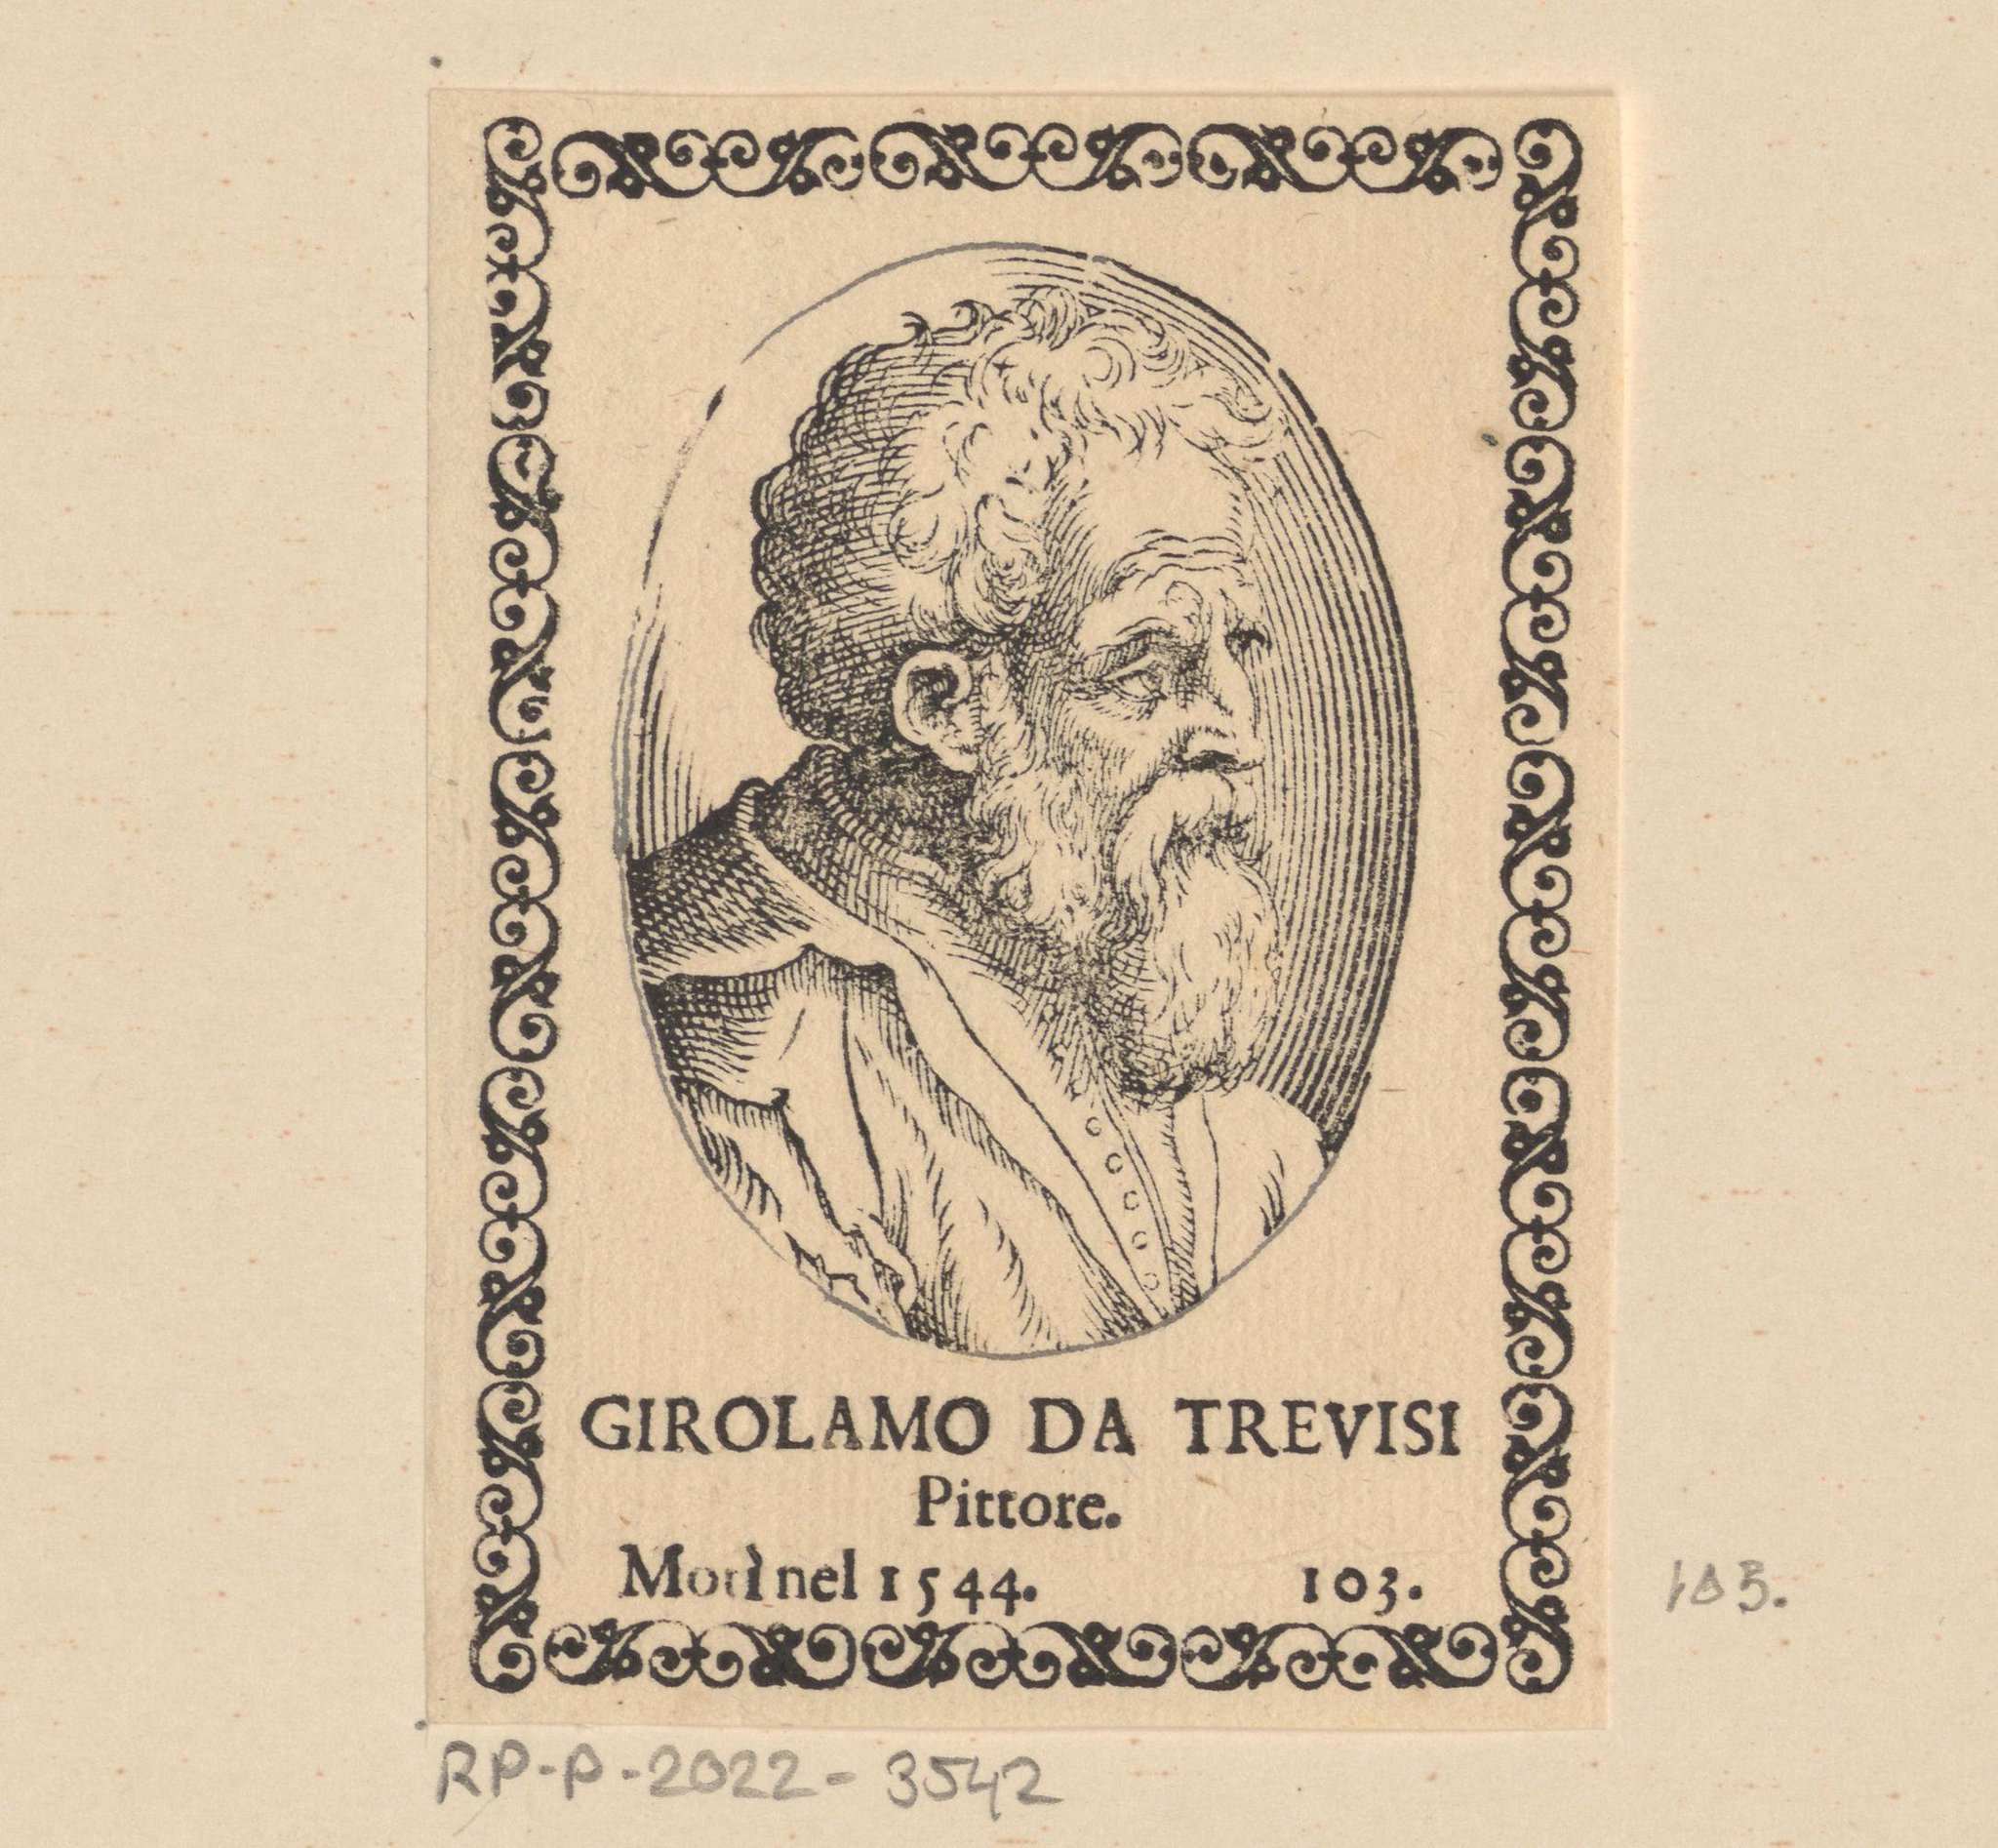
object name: print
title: Portret van Girolamo da Treviso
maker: cristoforo coriolano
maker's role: print maker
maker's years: 1540-1610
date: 1568-1663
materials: paper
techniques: woodcut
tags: painter, draughtsman, sculptor, girolamo da treviso (ii), historical persons, portrait, self-portrait of painter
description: Prent komt waarschijnlijk uit een editie van Vasari’s Vite. De prent is met een andere omlijsting gebruikt in de editie uit 1568, en mogelijk in de edities van 1647 en 1663. Waarschijnlijk zijn de houtsnedes met deze omlijsting gemaakt door Cristoforo Coriolano.